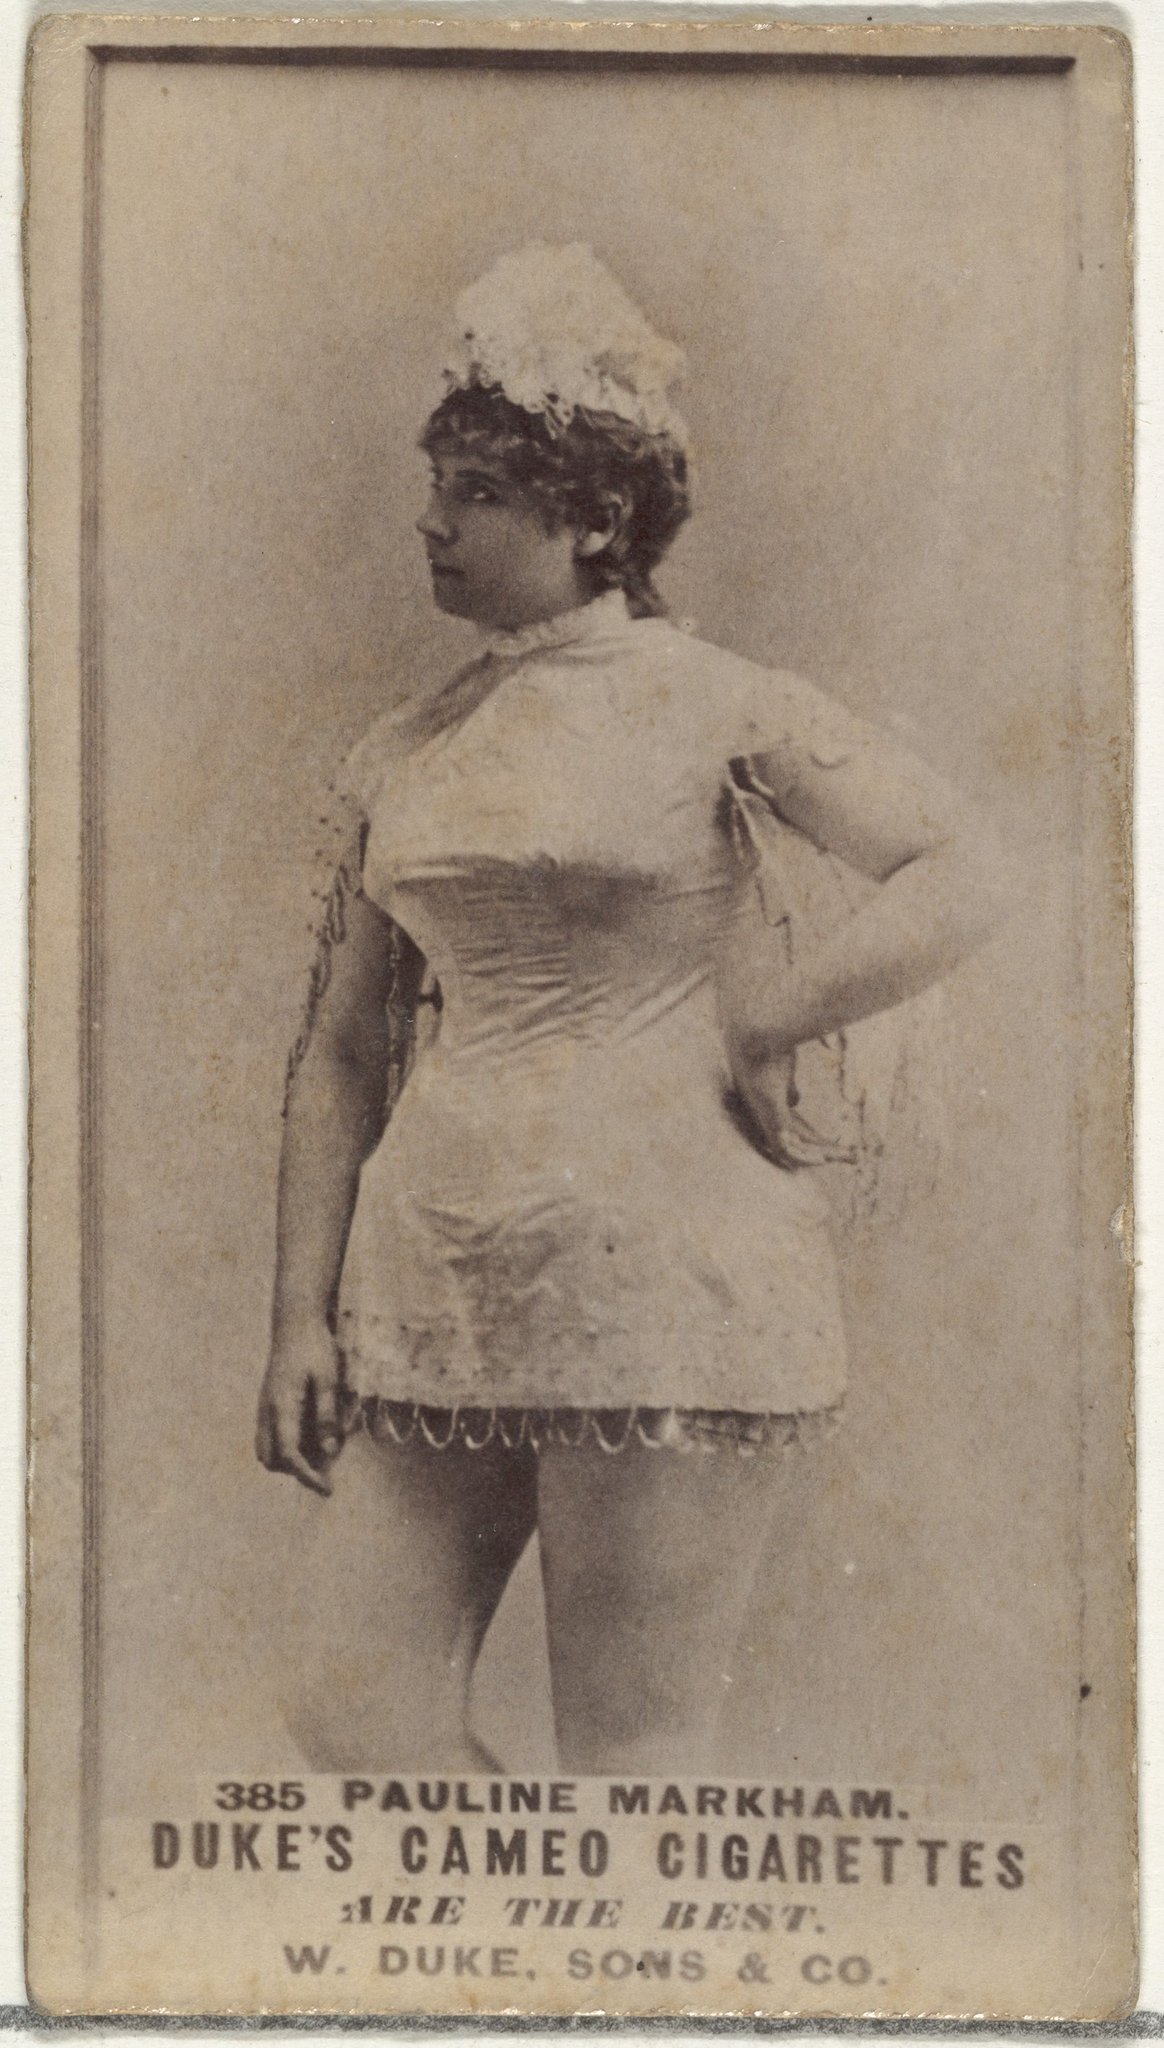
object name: photograph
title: Card Number 385, Pauline Markham, from the Actors and Actresses series (N145-5) issued by Duke Sons & Co. to promote Cameo Cigarettes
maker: w. duke, sons & co.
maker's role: publisher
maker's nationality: american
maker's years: 1870-1920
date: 1880-1889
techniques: albumen silver print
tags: women,actresses